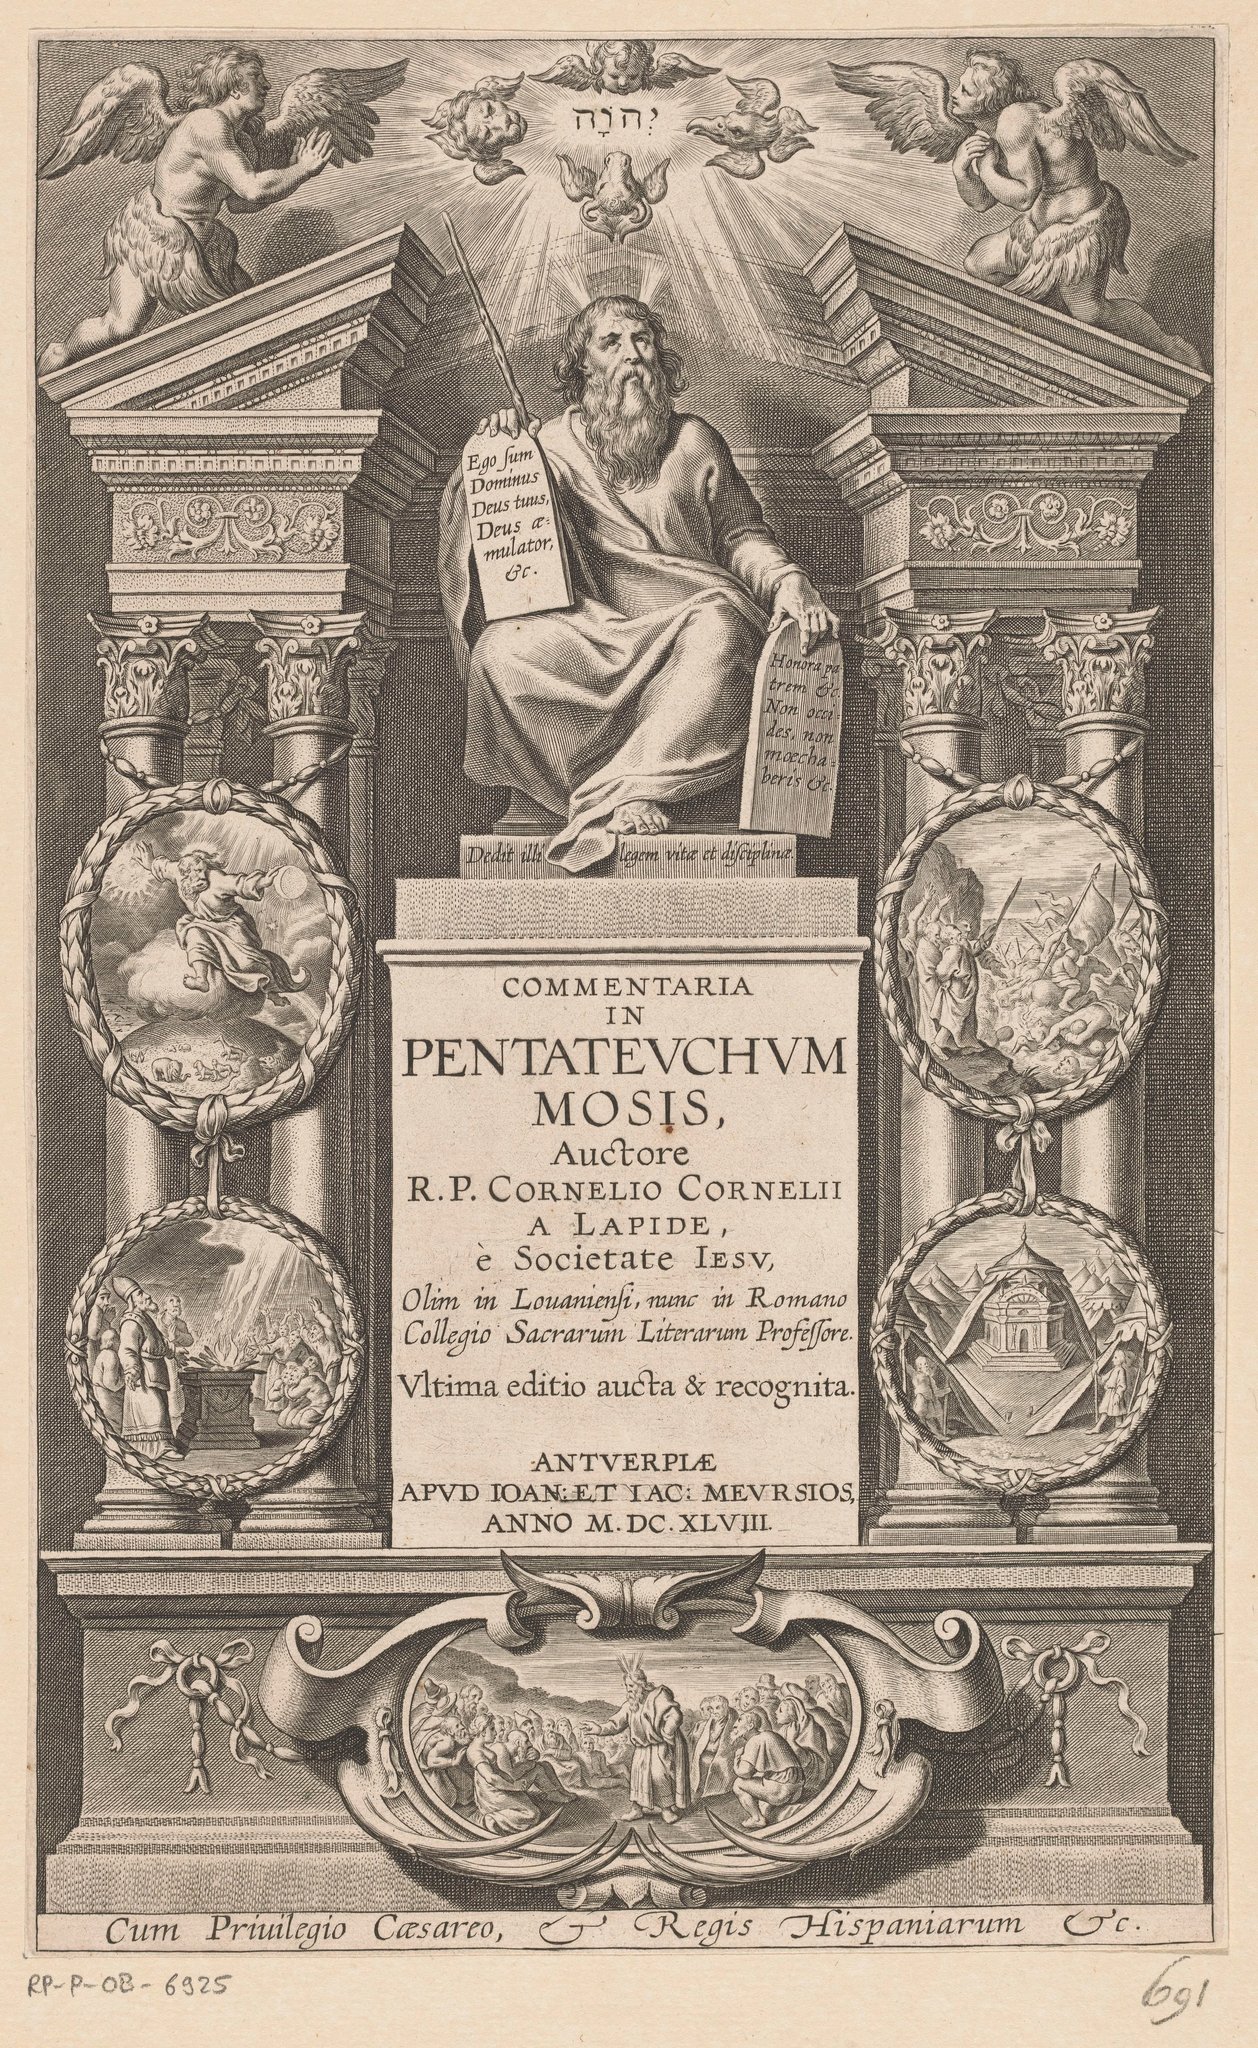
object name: titelblad, titelpagina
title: Titelpagina voor: C. van der Steen, Commentaria in Pentateuchum Mosis, Antwerpen, 1648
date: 1648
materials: paper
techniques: engraving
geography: antwerp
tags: the book leviticus, moses teaching (in general), division of light and darkness, moses (not in biblical context); possible attributes: rays of light or horns on his head, rod, tables of the law, passage through the red sea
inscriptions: collector's mark: Lugt 240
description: Mozes met de wetstafelen tronend op een piëdestal met de titel van het boek. Aan weerszijden en onder vijf cartouches met scènes uit de eerste vijf bijbelboeken van het Oude Testament, de Pentateuch.